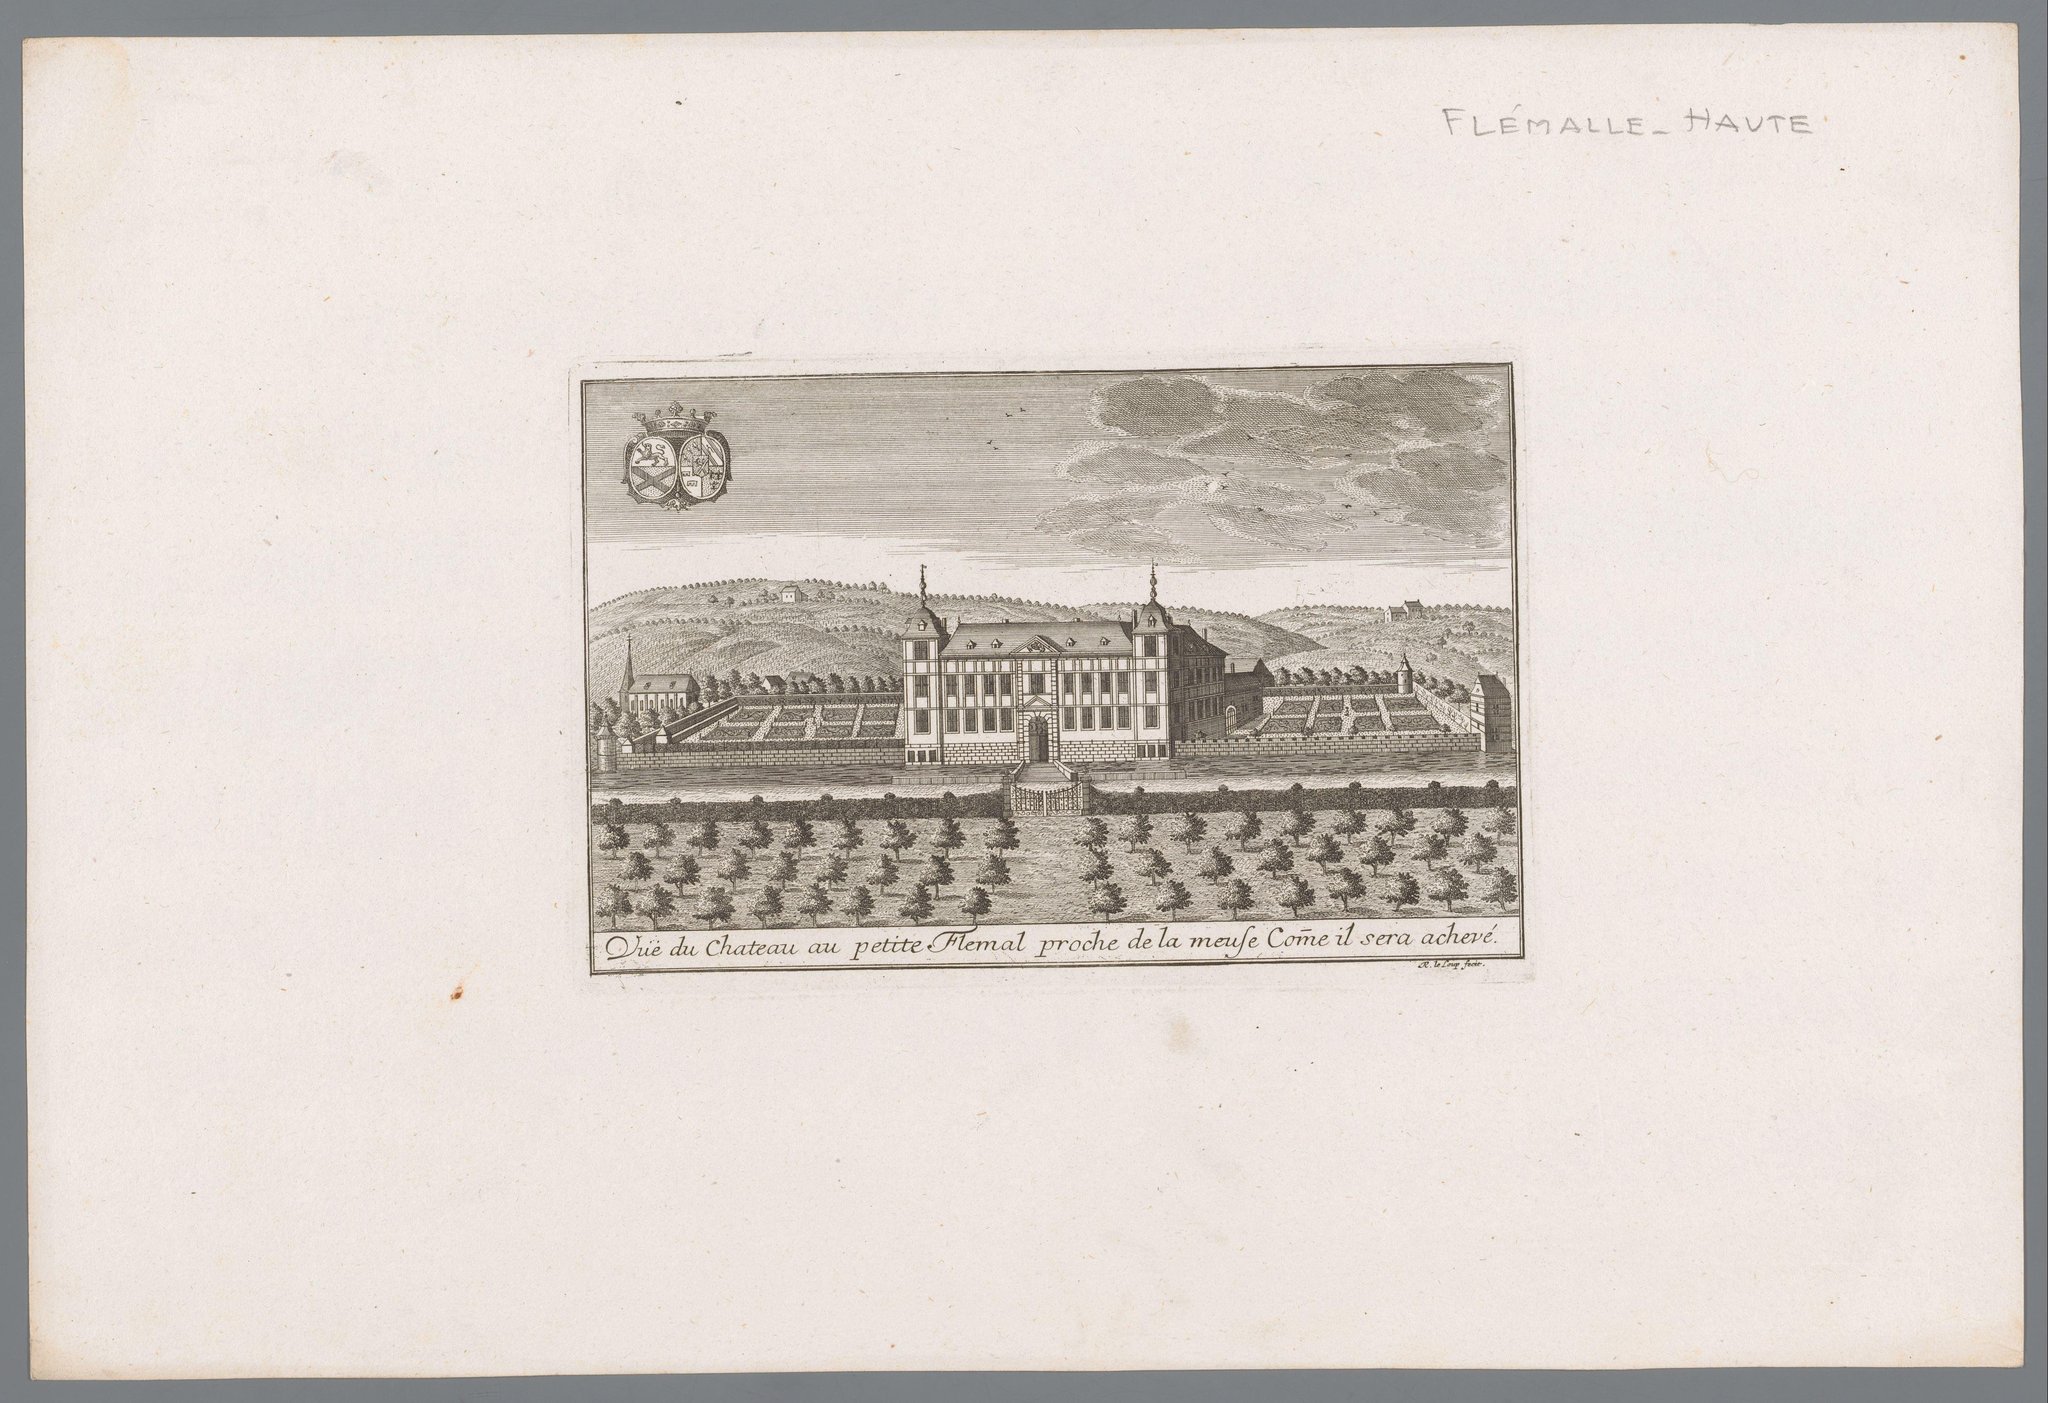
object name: print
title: Vue du chateau au petite Flemal proche de la Meuse comme il sera achevé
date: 1738-1744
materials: paper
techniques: engraving, etching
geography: liège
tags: castle, landscape with tower or castle, liège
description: Prent uit: Johanne de Saumery, Alexandre de et al. Les délices du païs de Liège, ou description géographique, topographique et chorographique des monumes sacrés et profanes (...). 5 dln. Luik: Everard Kints, 1738-1744, dl. 1, voor p. 344.